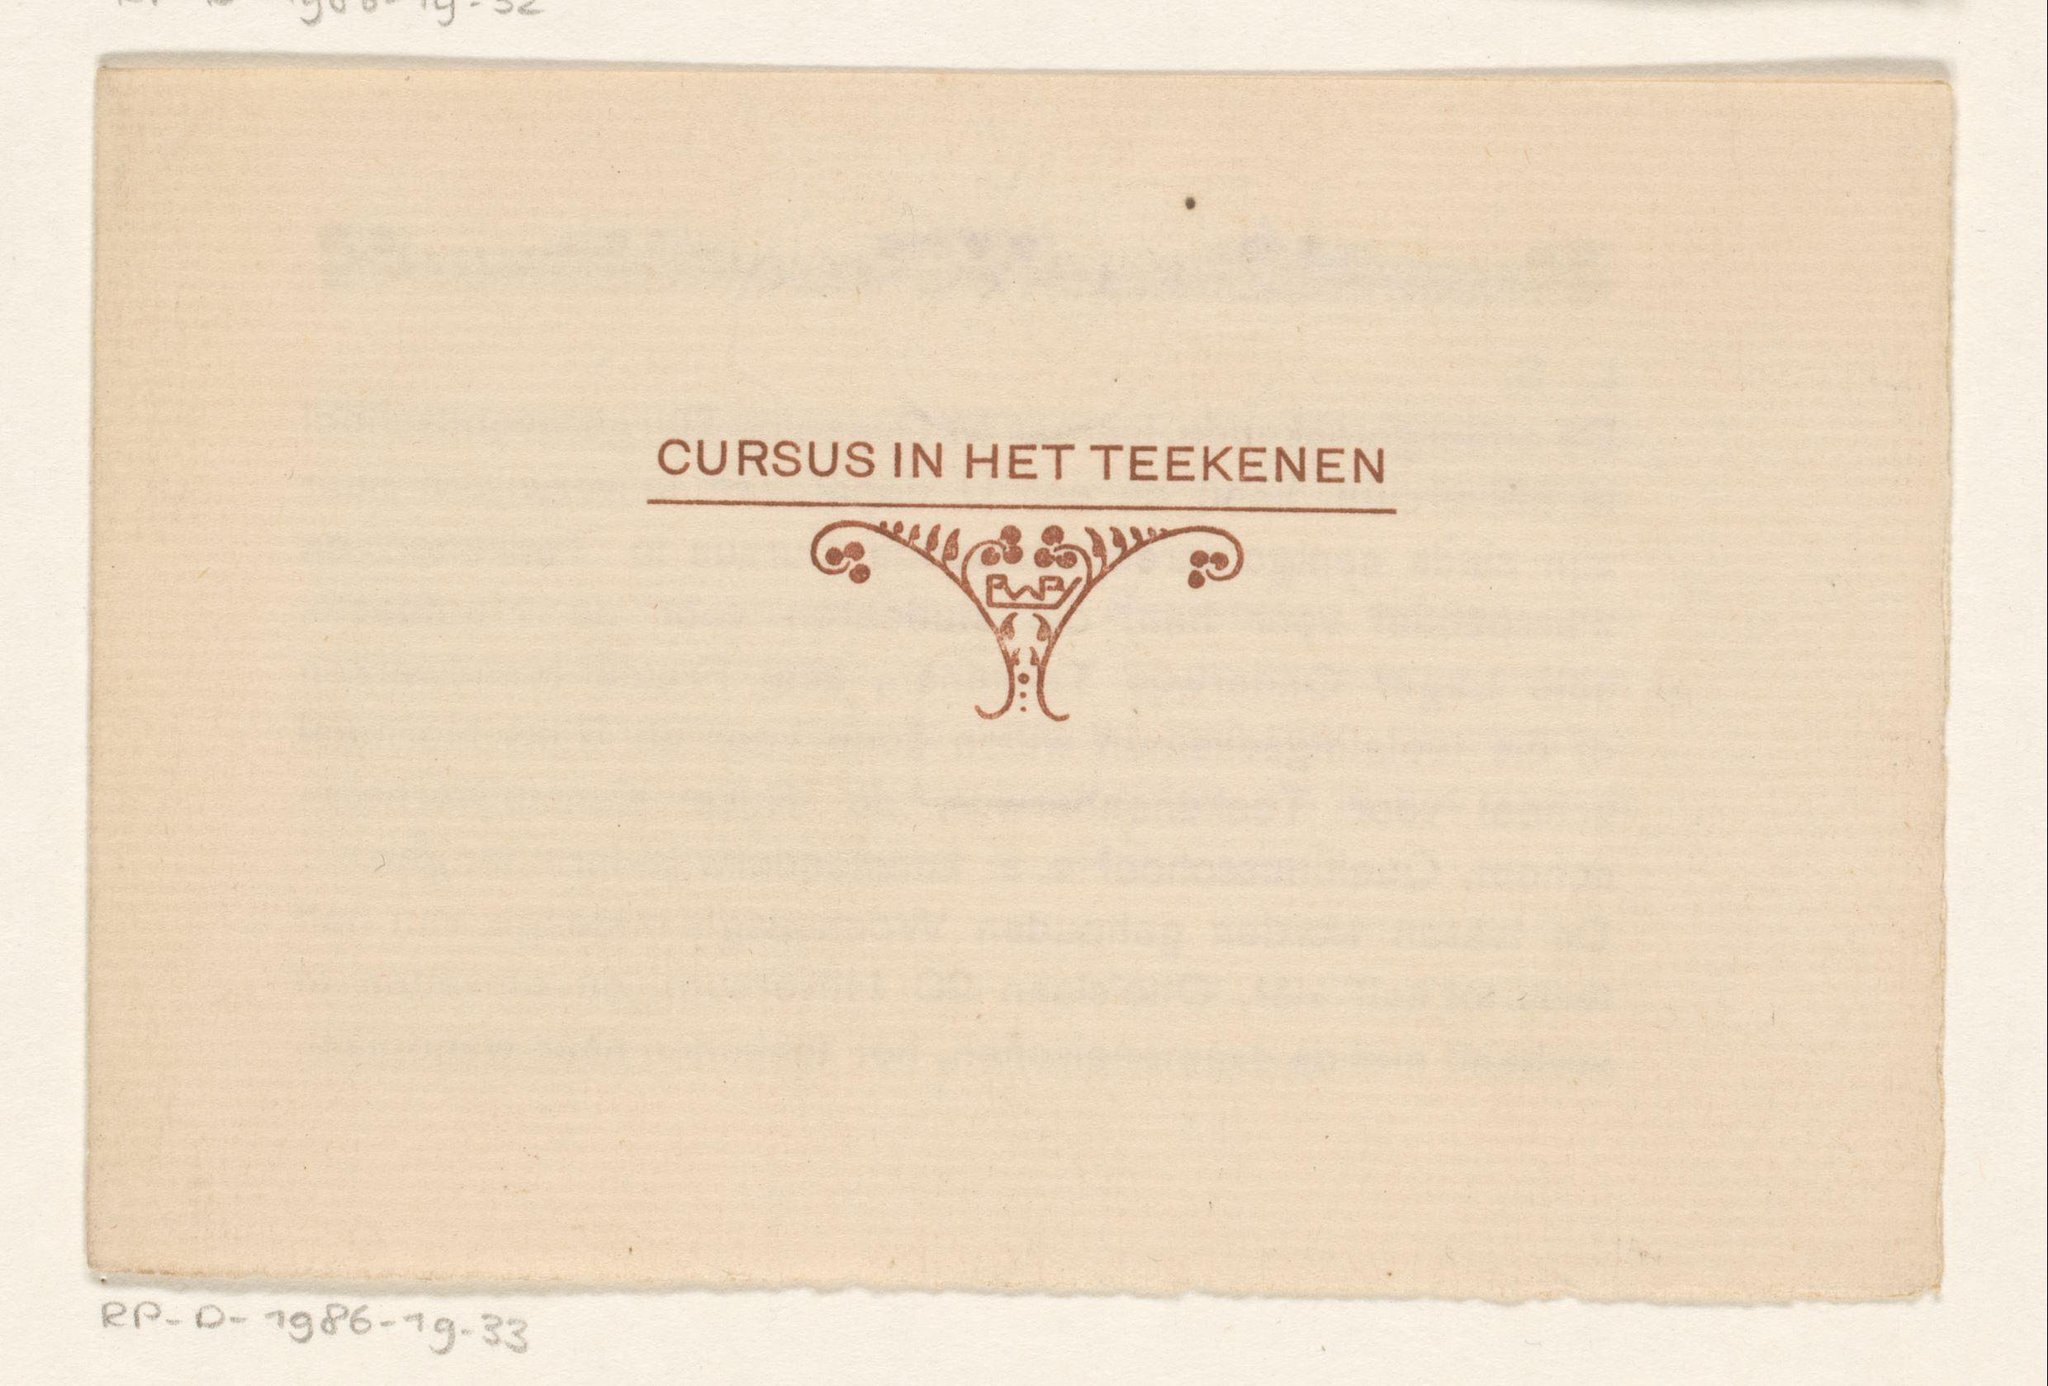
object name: advertising card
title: Reclamekaart voor tekenlessen door R.W.P. de Vries Jr.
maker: reinier willem petrus de vries (1874-1953)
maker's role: draughtsman, print maker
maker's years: 1874-1953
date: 1884-1952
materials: paper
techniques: relief print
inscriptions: collector's mark: ‘R:MVS.’